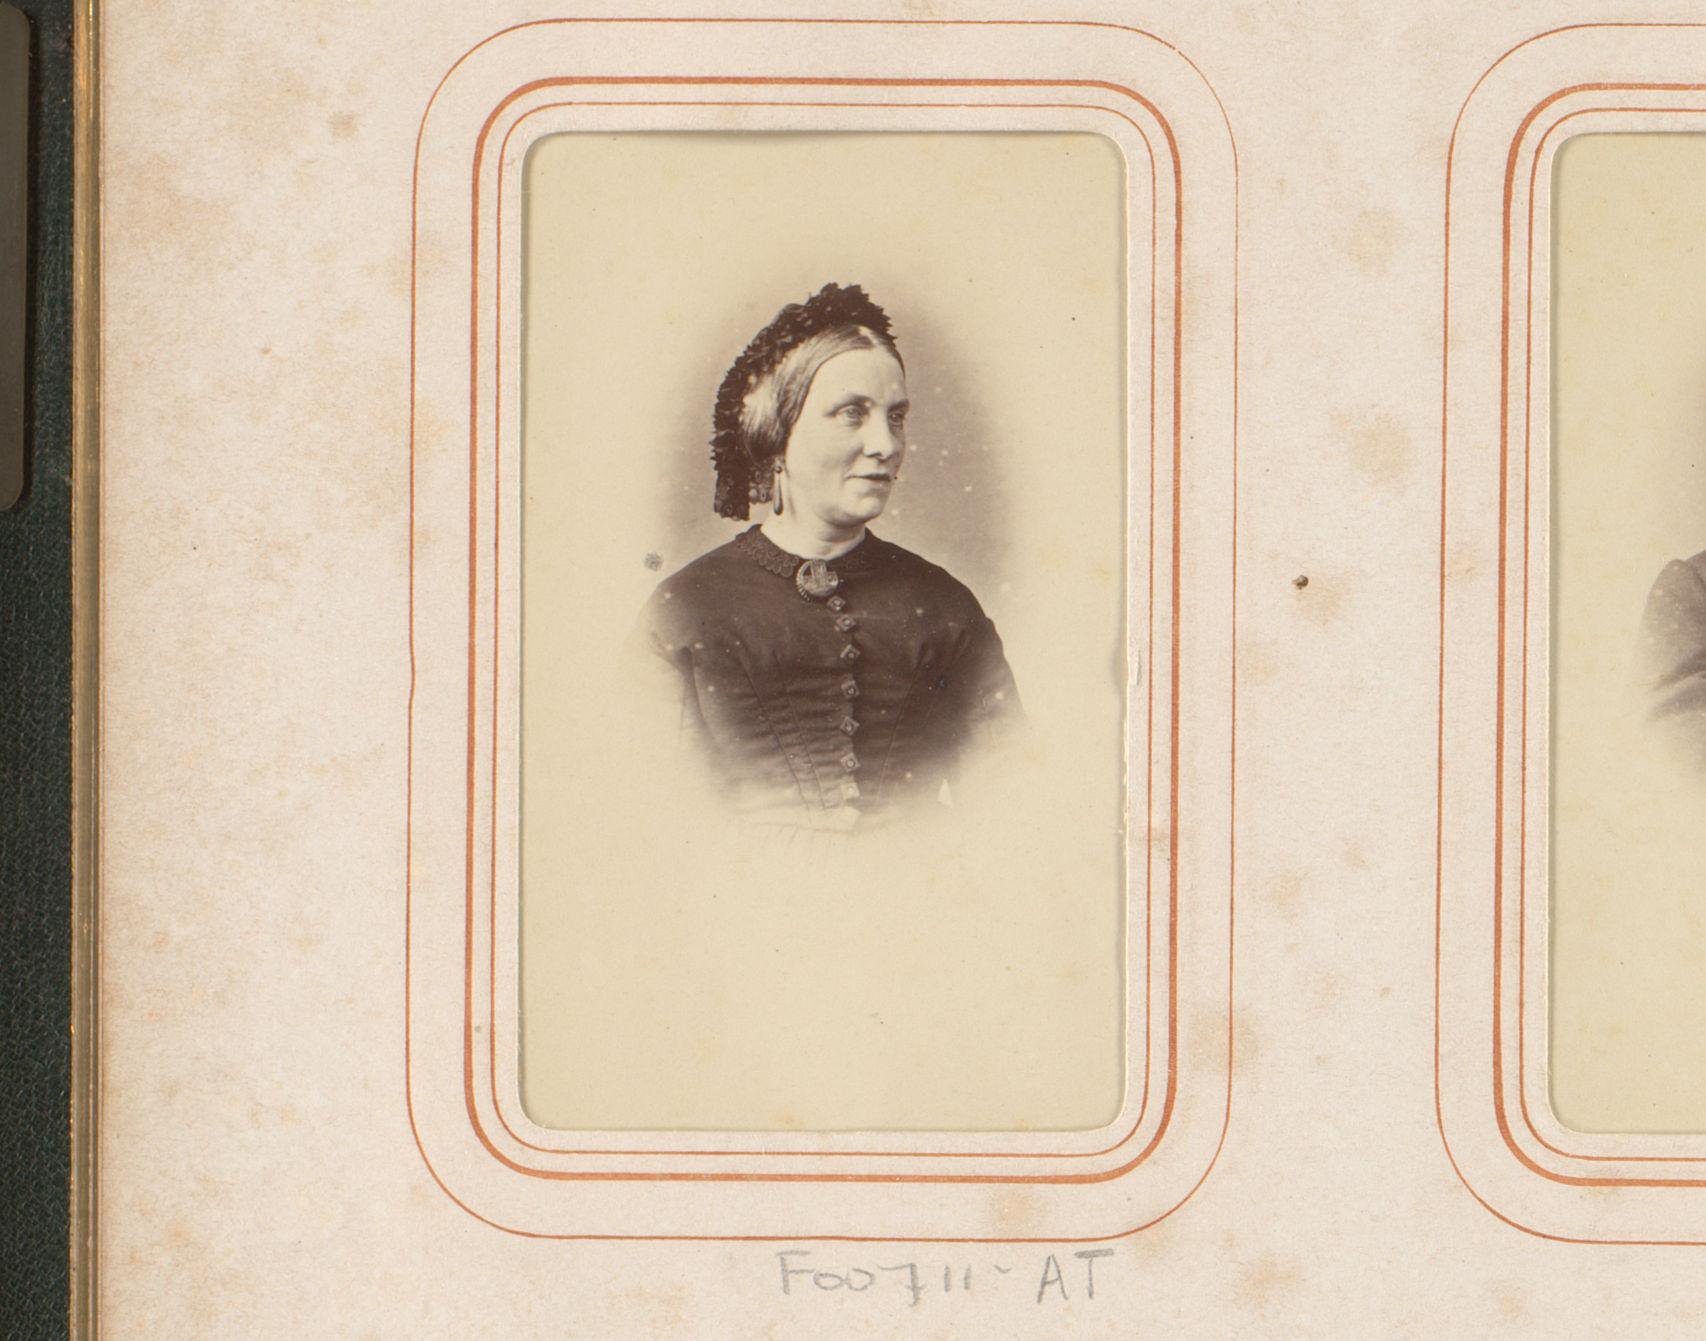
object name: carte de visite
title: Portret van een vrouw met muts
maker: christiaan martinus jan hermelink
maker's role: fotograaf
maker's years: 1840-1933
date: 1869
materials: cardboard, photographic support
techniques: albumen print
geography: delft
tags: historical persons - bb - woman, head-gear: cap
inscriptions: inscription: ‘Photographisch Instituut/ Delft/ Oude Delft/ W 5, No 527’